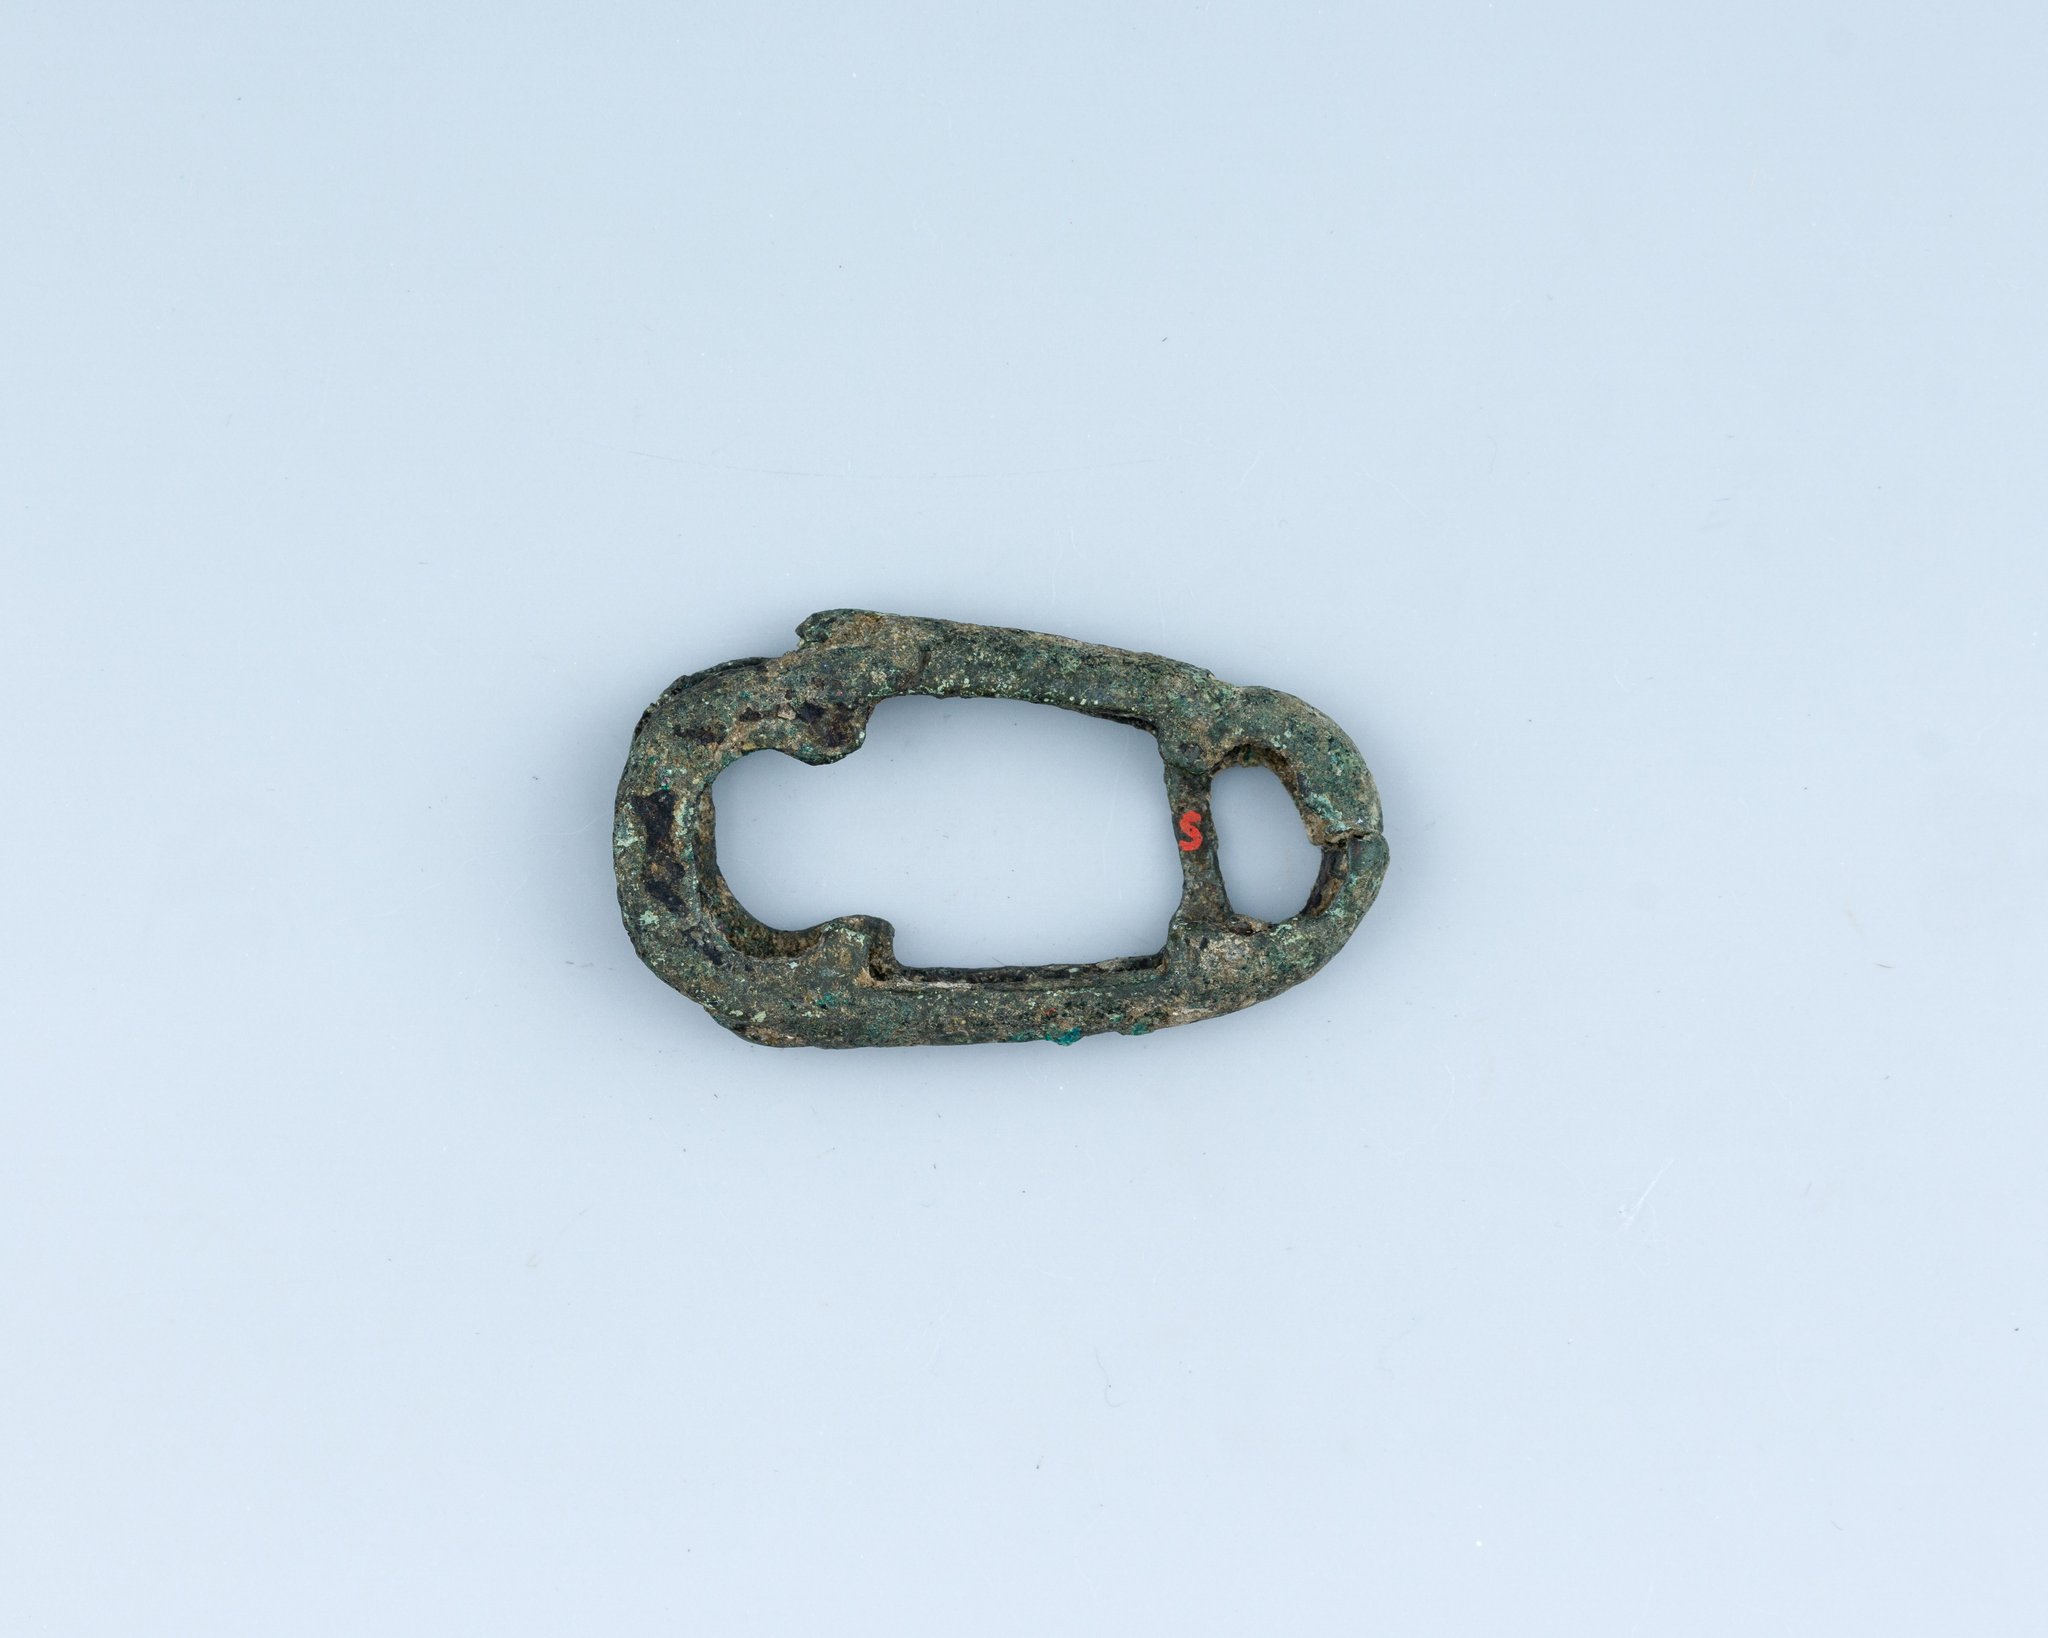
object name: mordant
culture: european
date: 1401-1700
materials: bronze